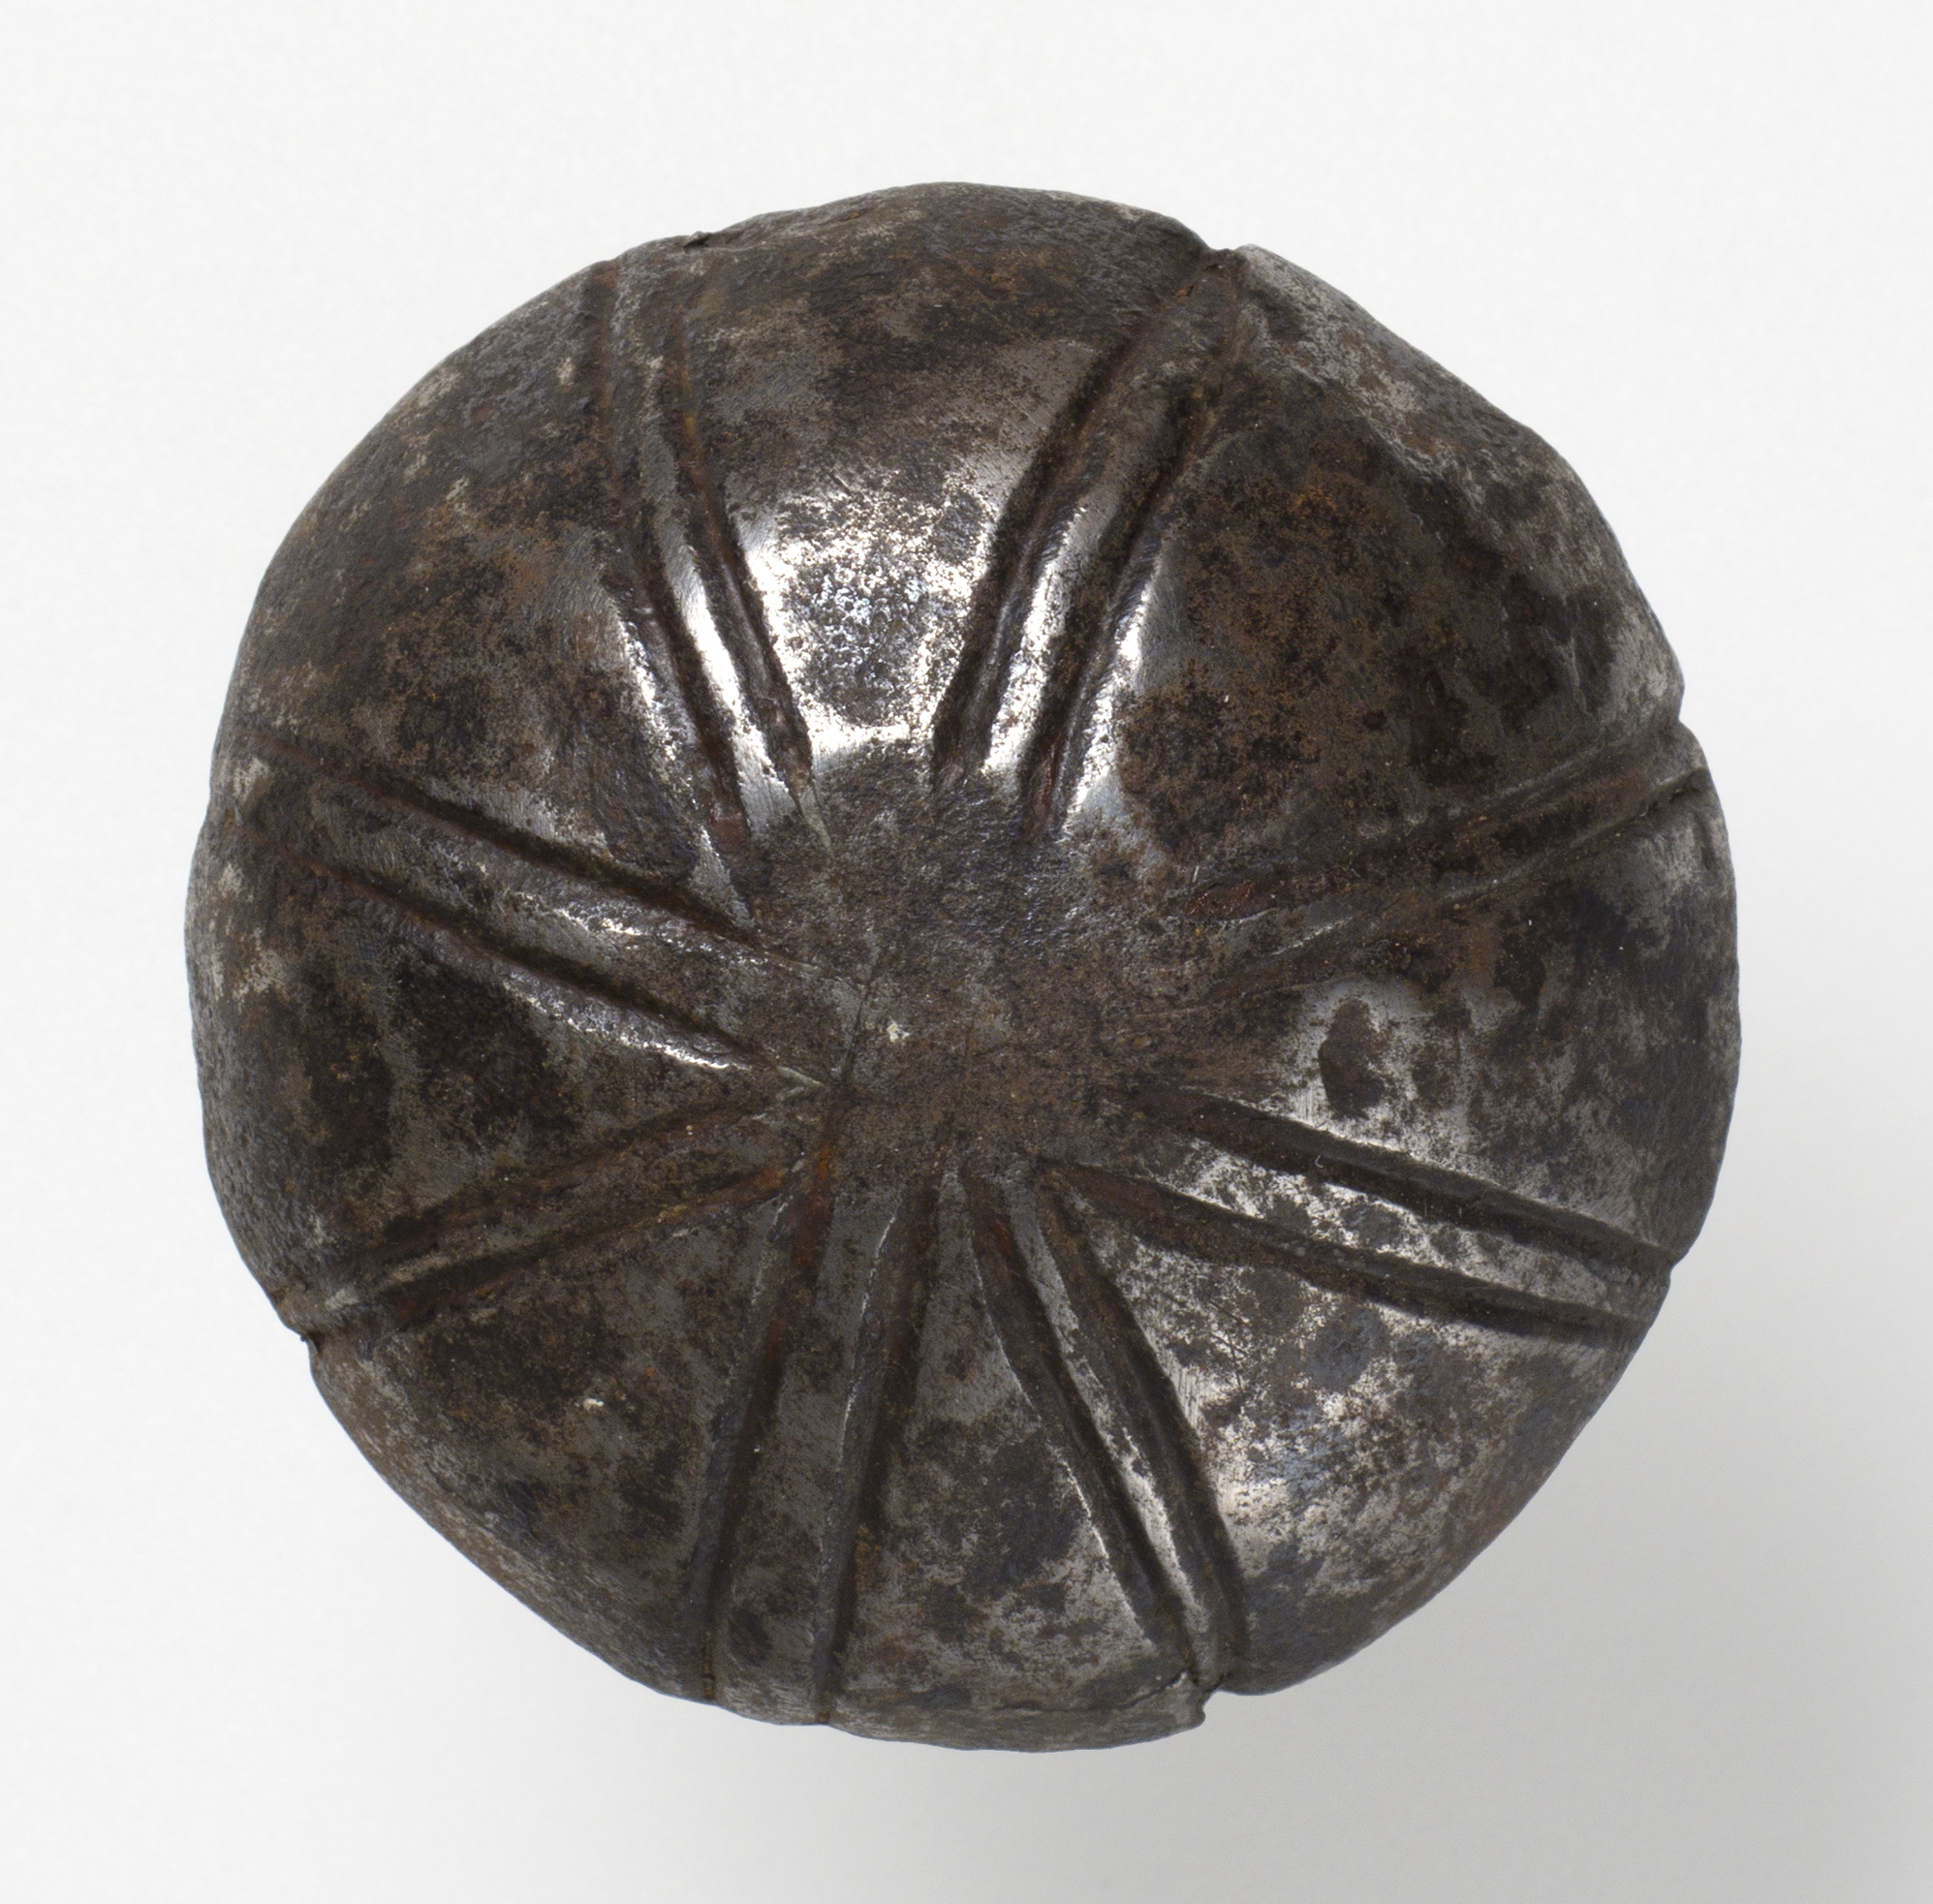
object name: nail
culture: european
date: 1401-1600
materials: iron